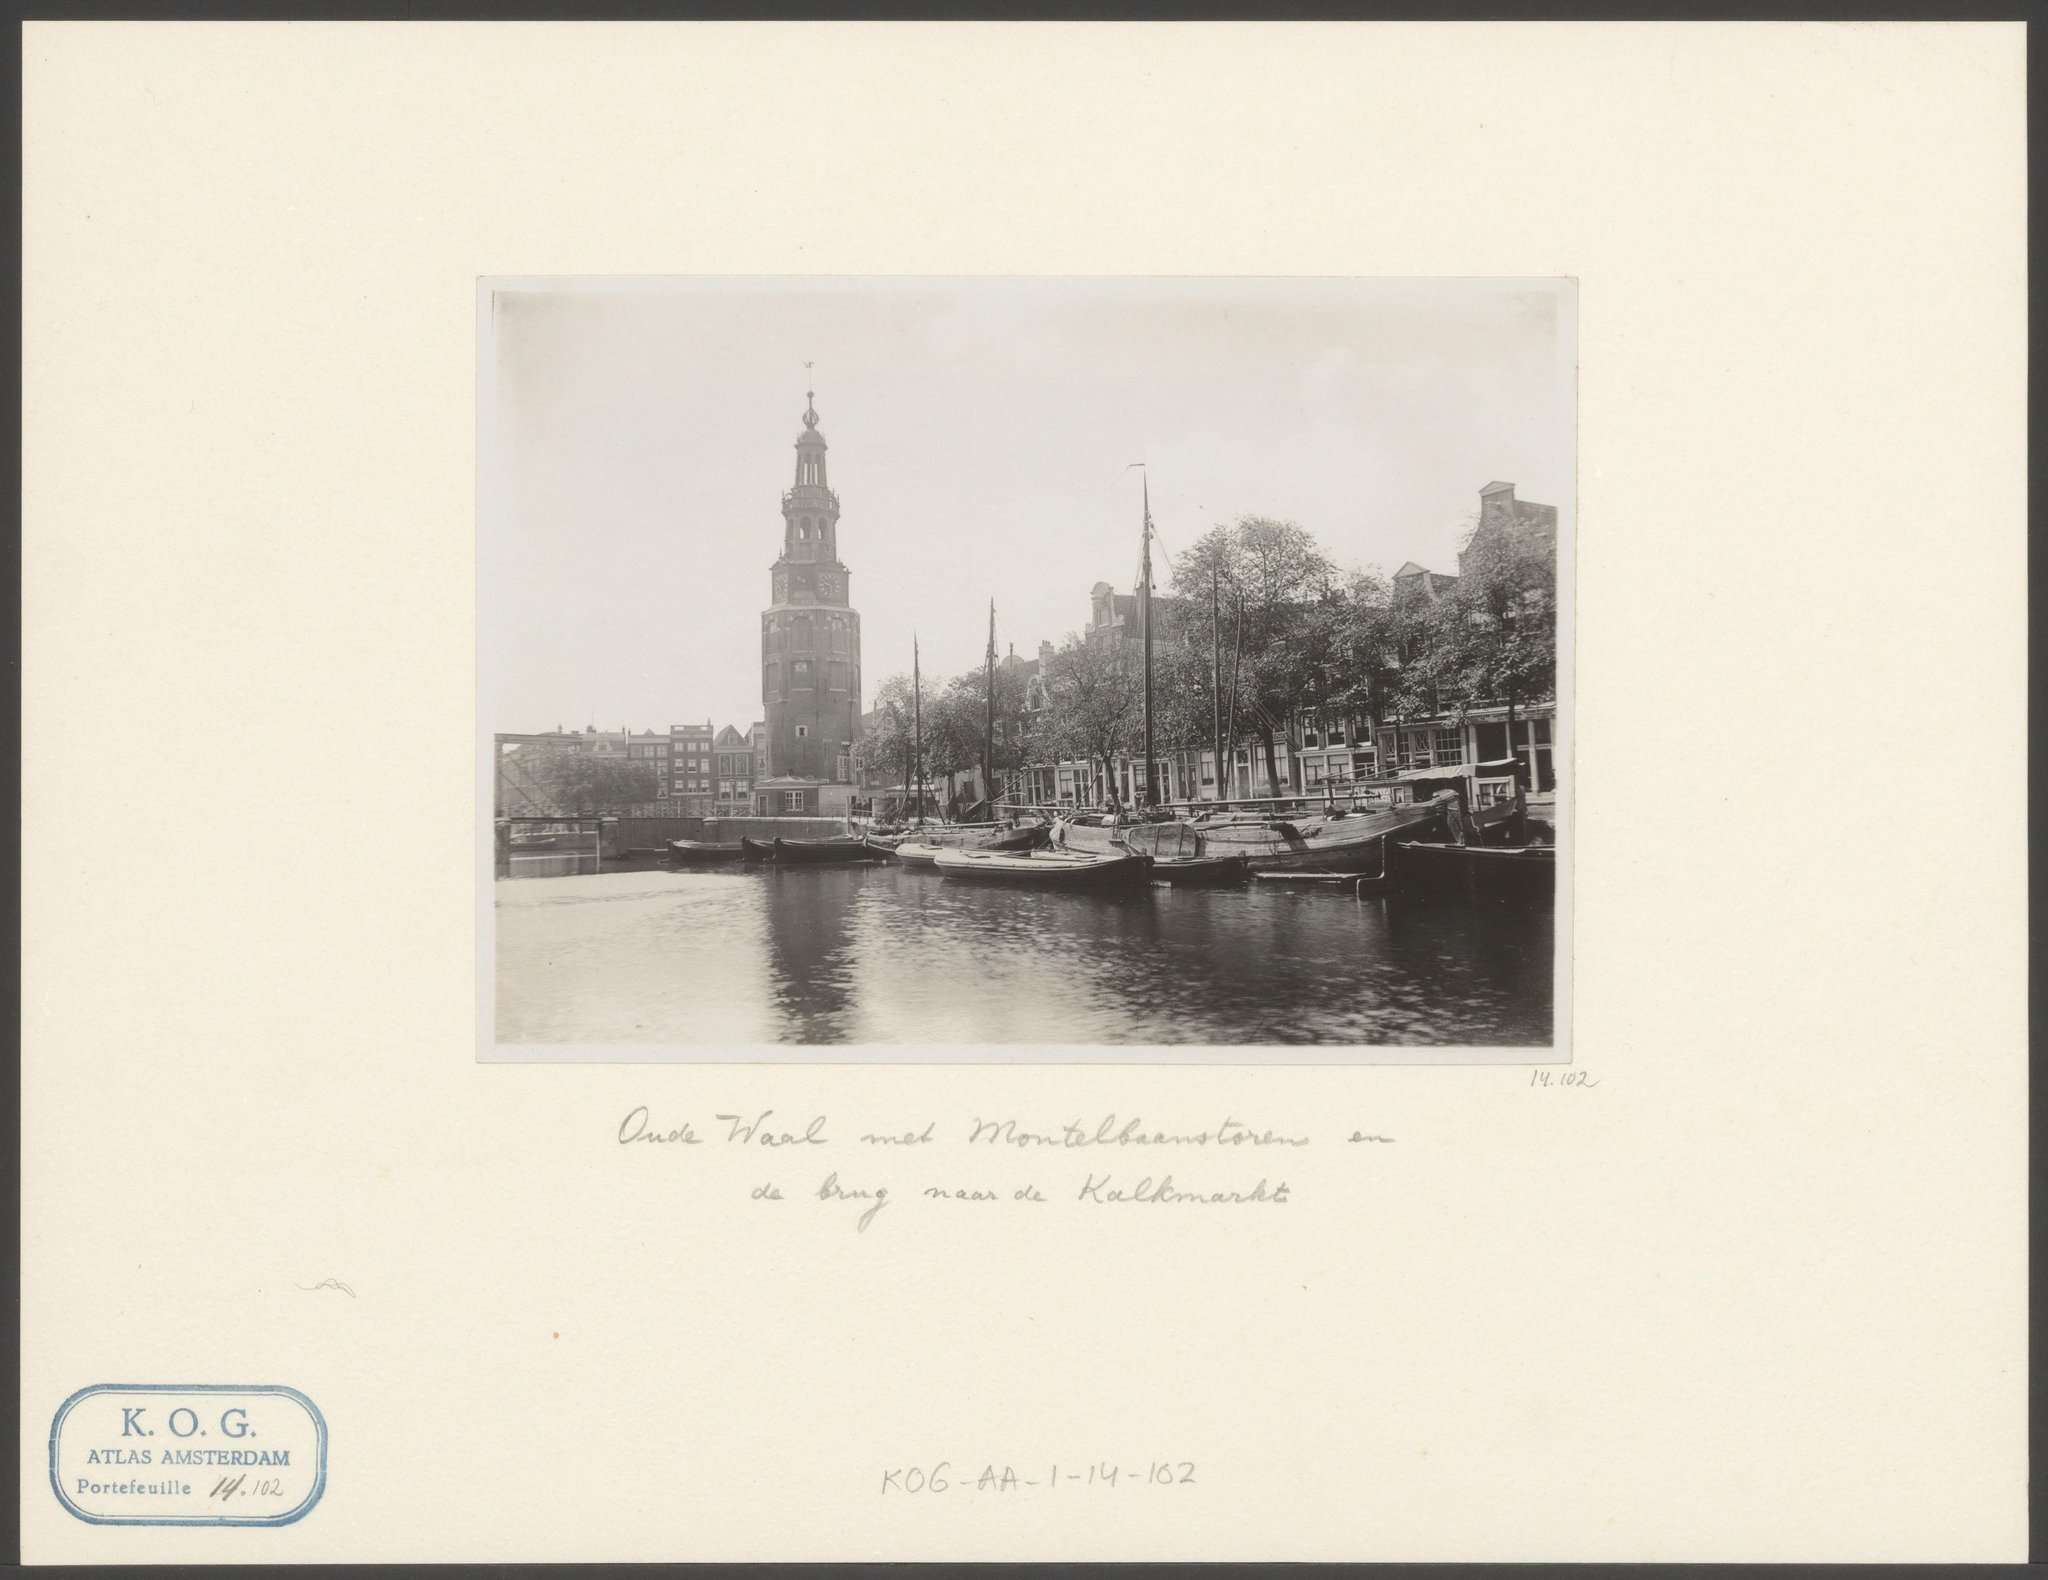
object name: photograph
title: Gezicht op de Oude Waal met de Montelbaanstoren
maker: Anonymous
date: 1880-1950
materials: paper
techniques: gelatin silver print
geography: amsterdam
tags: tower, clock tower ~ monumental adornment, city-view in general; 'veduta', canal, bridge in city across river, canal, etc.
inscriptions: inscription: ‘Oude Waal met Montelbaanstoren en / de brug naar de Kalkmarkt’, collector's mark: ‘14.102’ Lugt 1641b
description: Onderwerpsrubriek binnen de Atlas Amsterdam: Waal (Kromme en Oude), Walenpleintje, Warmoesgracht, Warmoesstraat, Waterlooplein, Westerdoksdijk, Westermarkt, Weteringschans, Willemspark, Willemsstraat, Wittenburg, Wittenkade (de), Wittenstraat (de).